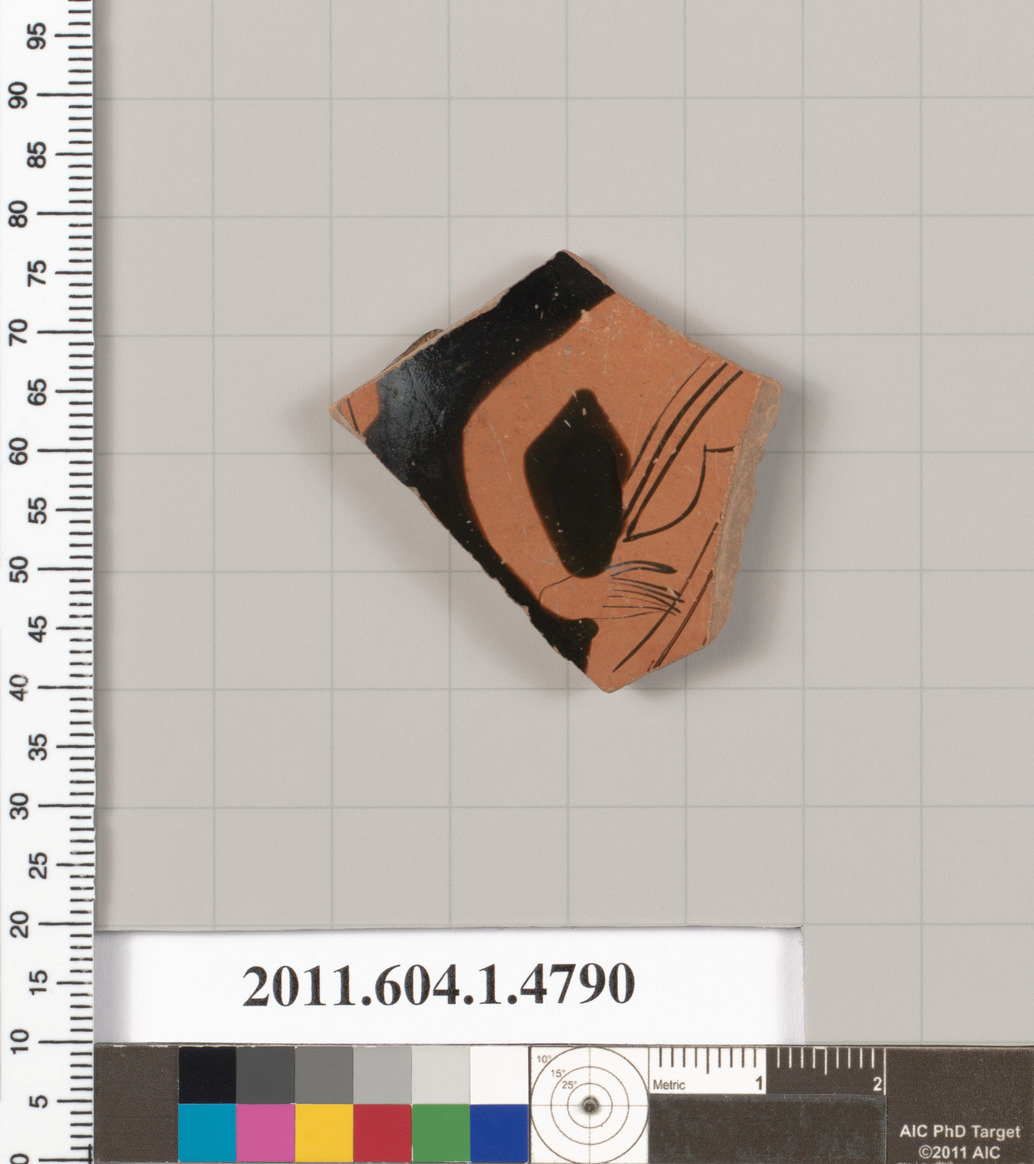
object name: kylix fragment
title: Terracotta fragment of a kylix (drinking cup)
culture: greek, attic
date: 460-450 BCE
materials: terracotta